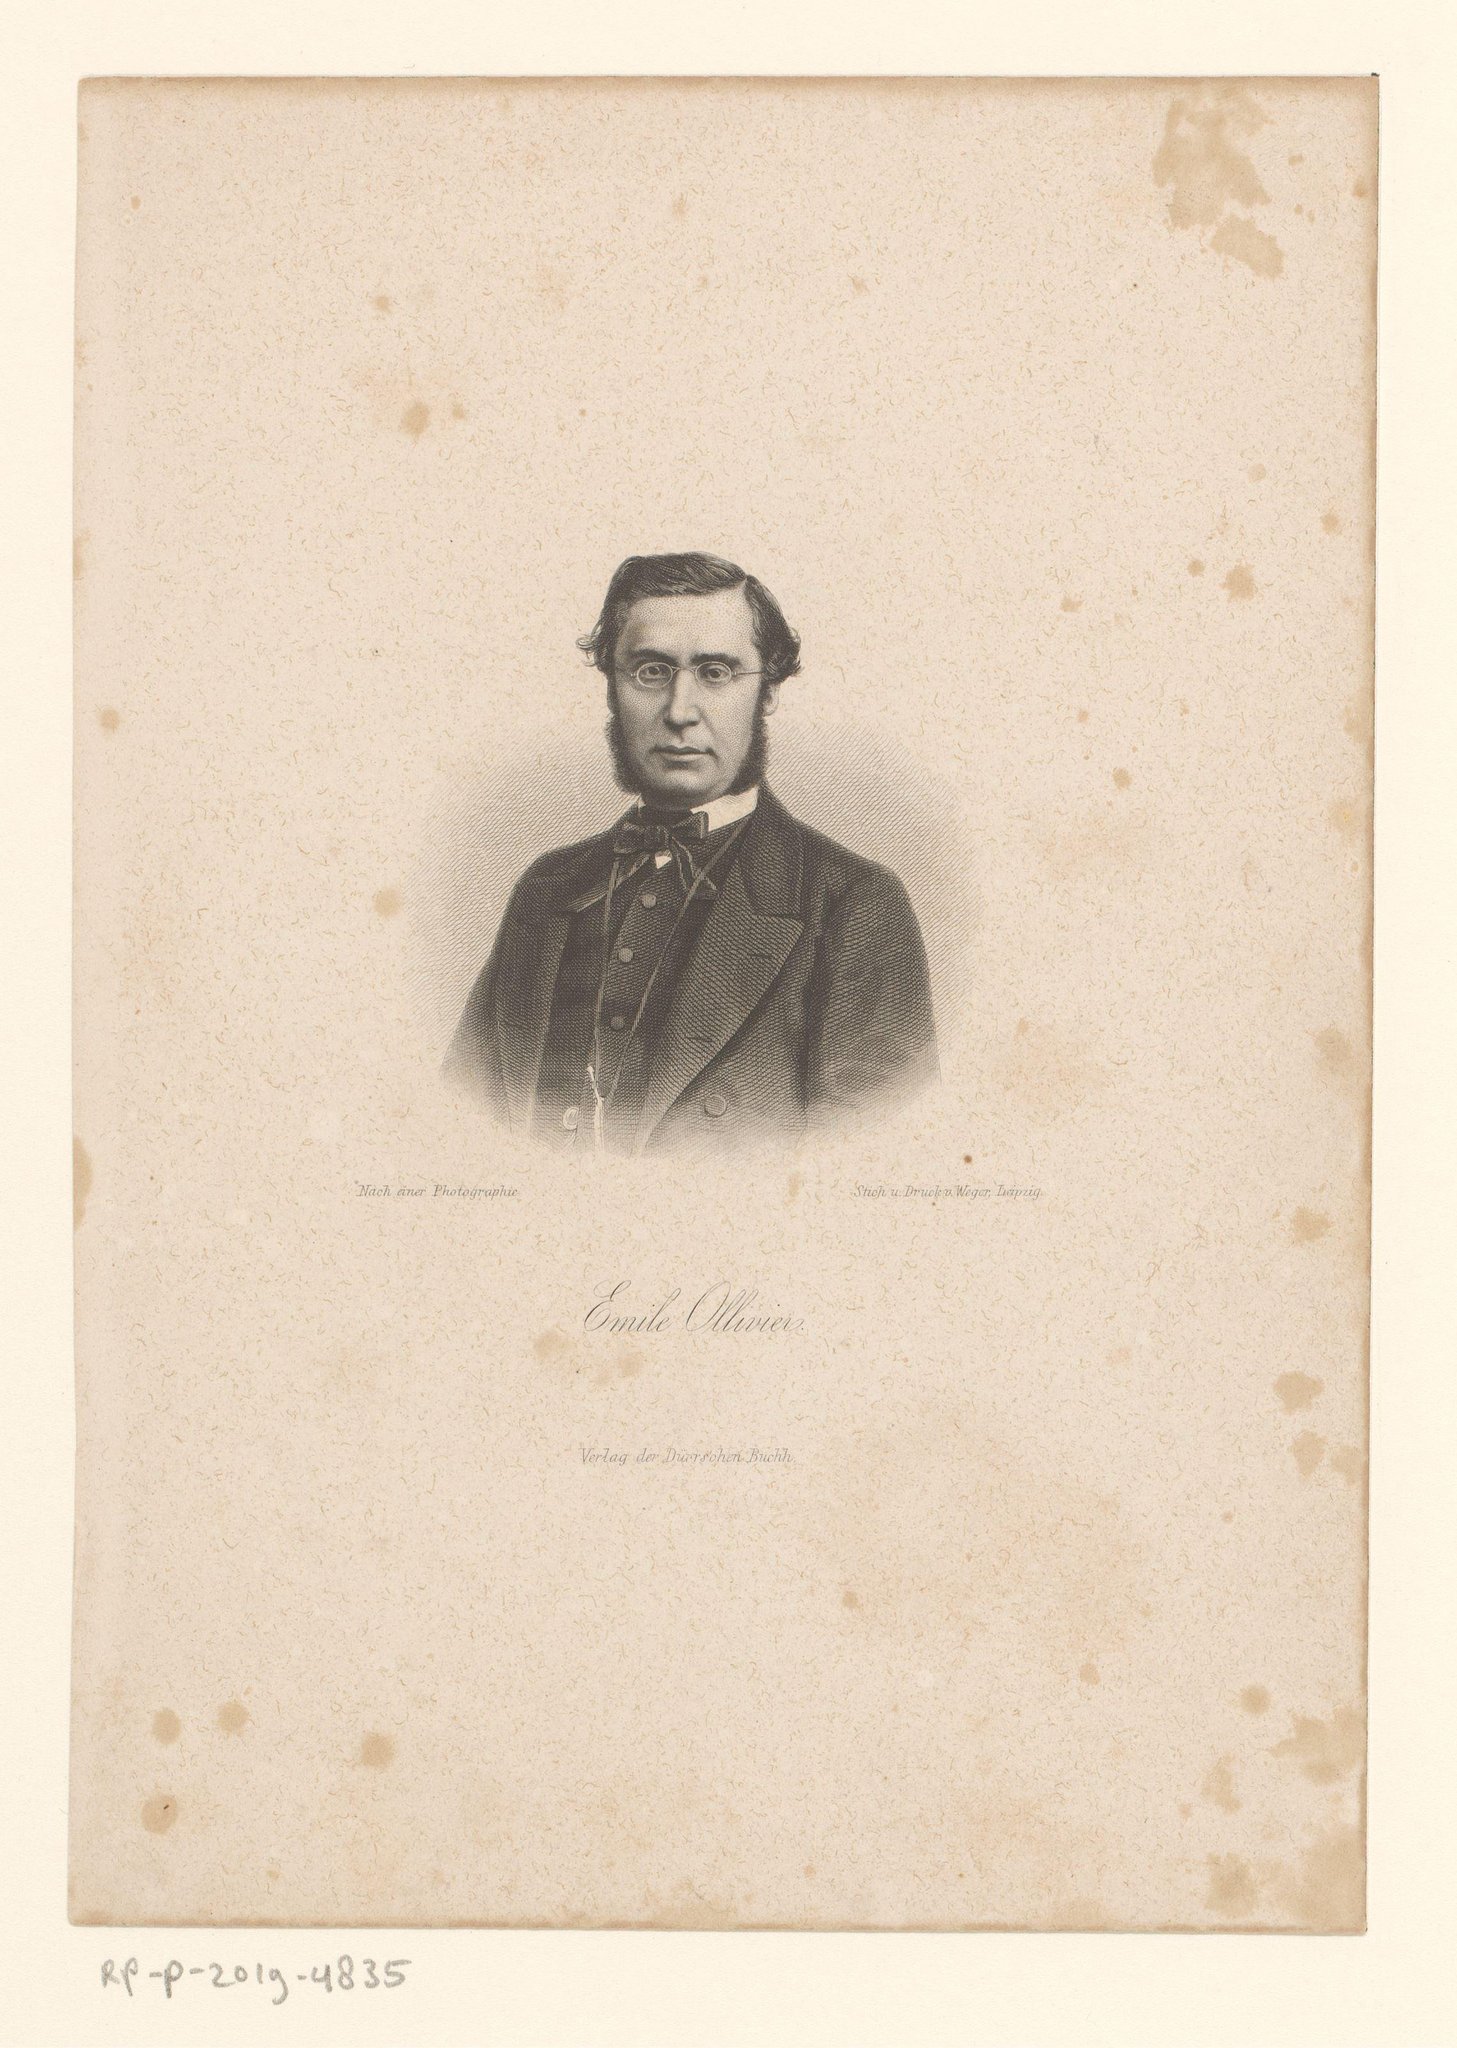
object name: print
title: Portret van Émile Ollivier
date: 1870-1892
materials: paper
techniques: etching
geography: leipzig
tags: politician, historical persons, politician, e.g. party leader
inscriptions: collector's mark: Lugt 2228, collector's mark: Lugt 2760, collector's mark: ‘Franz Radestom [?]’